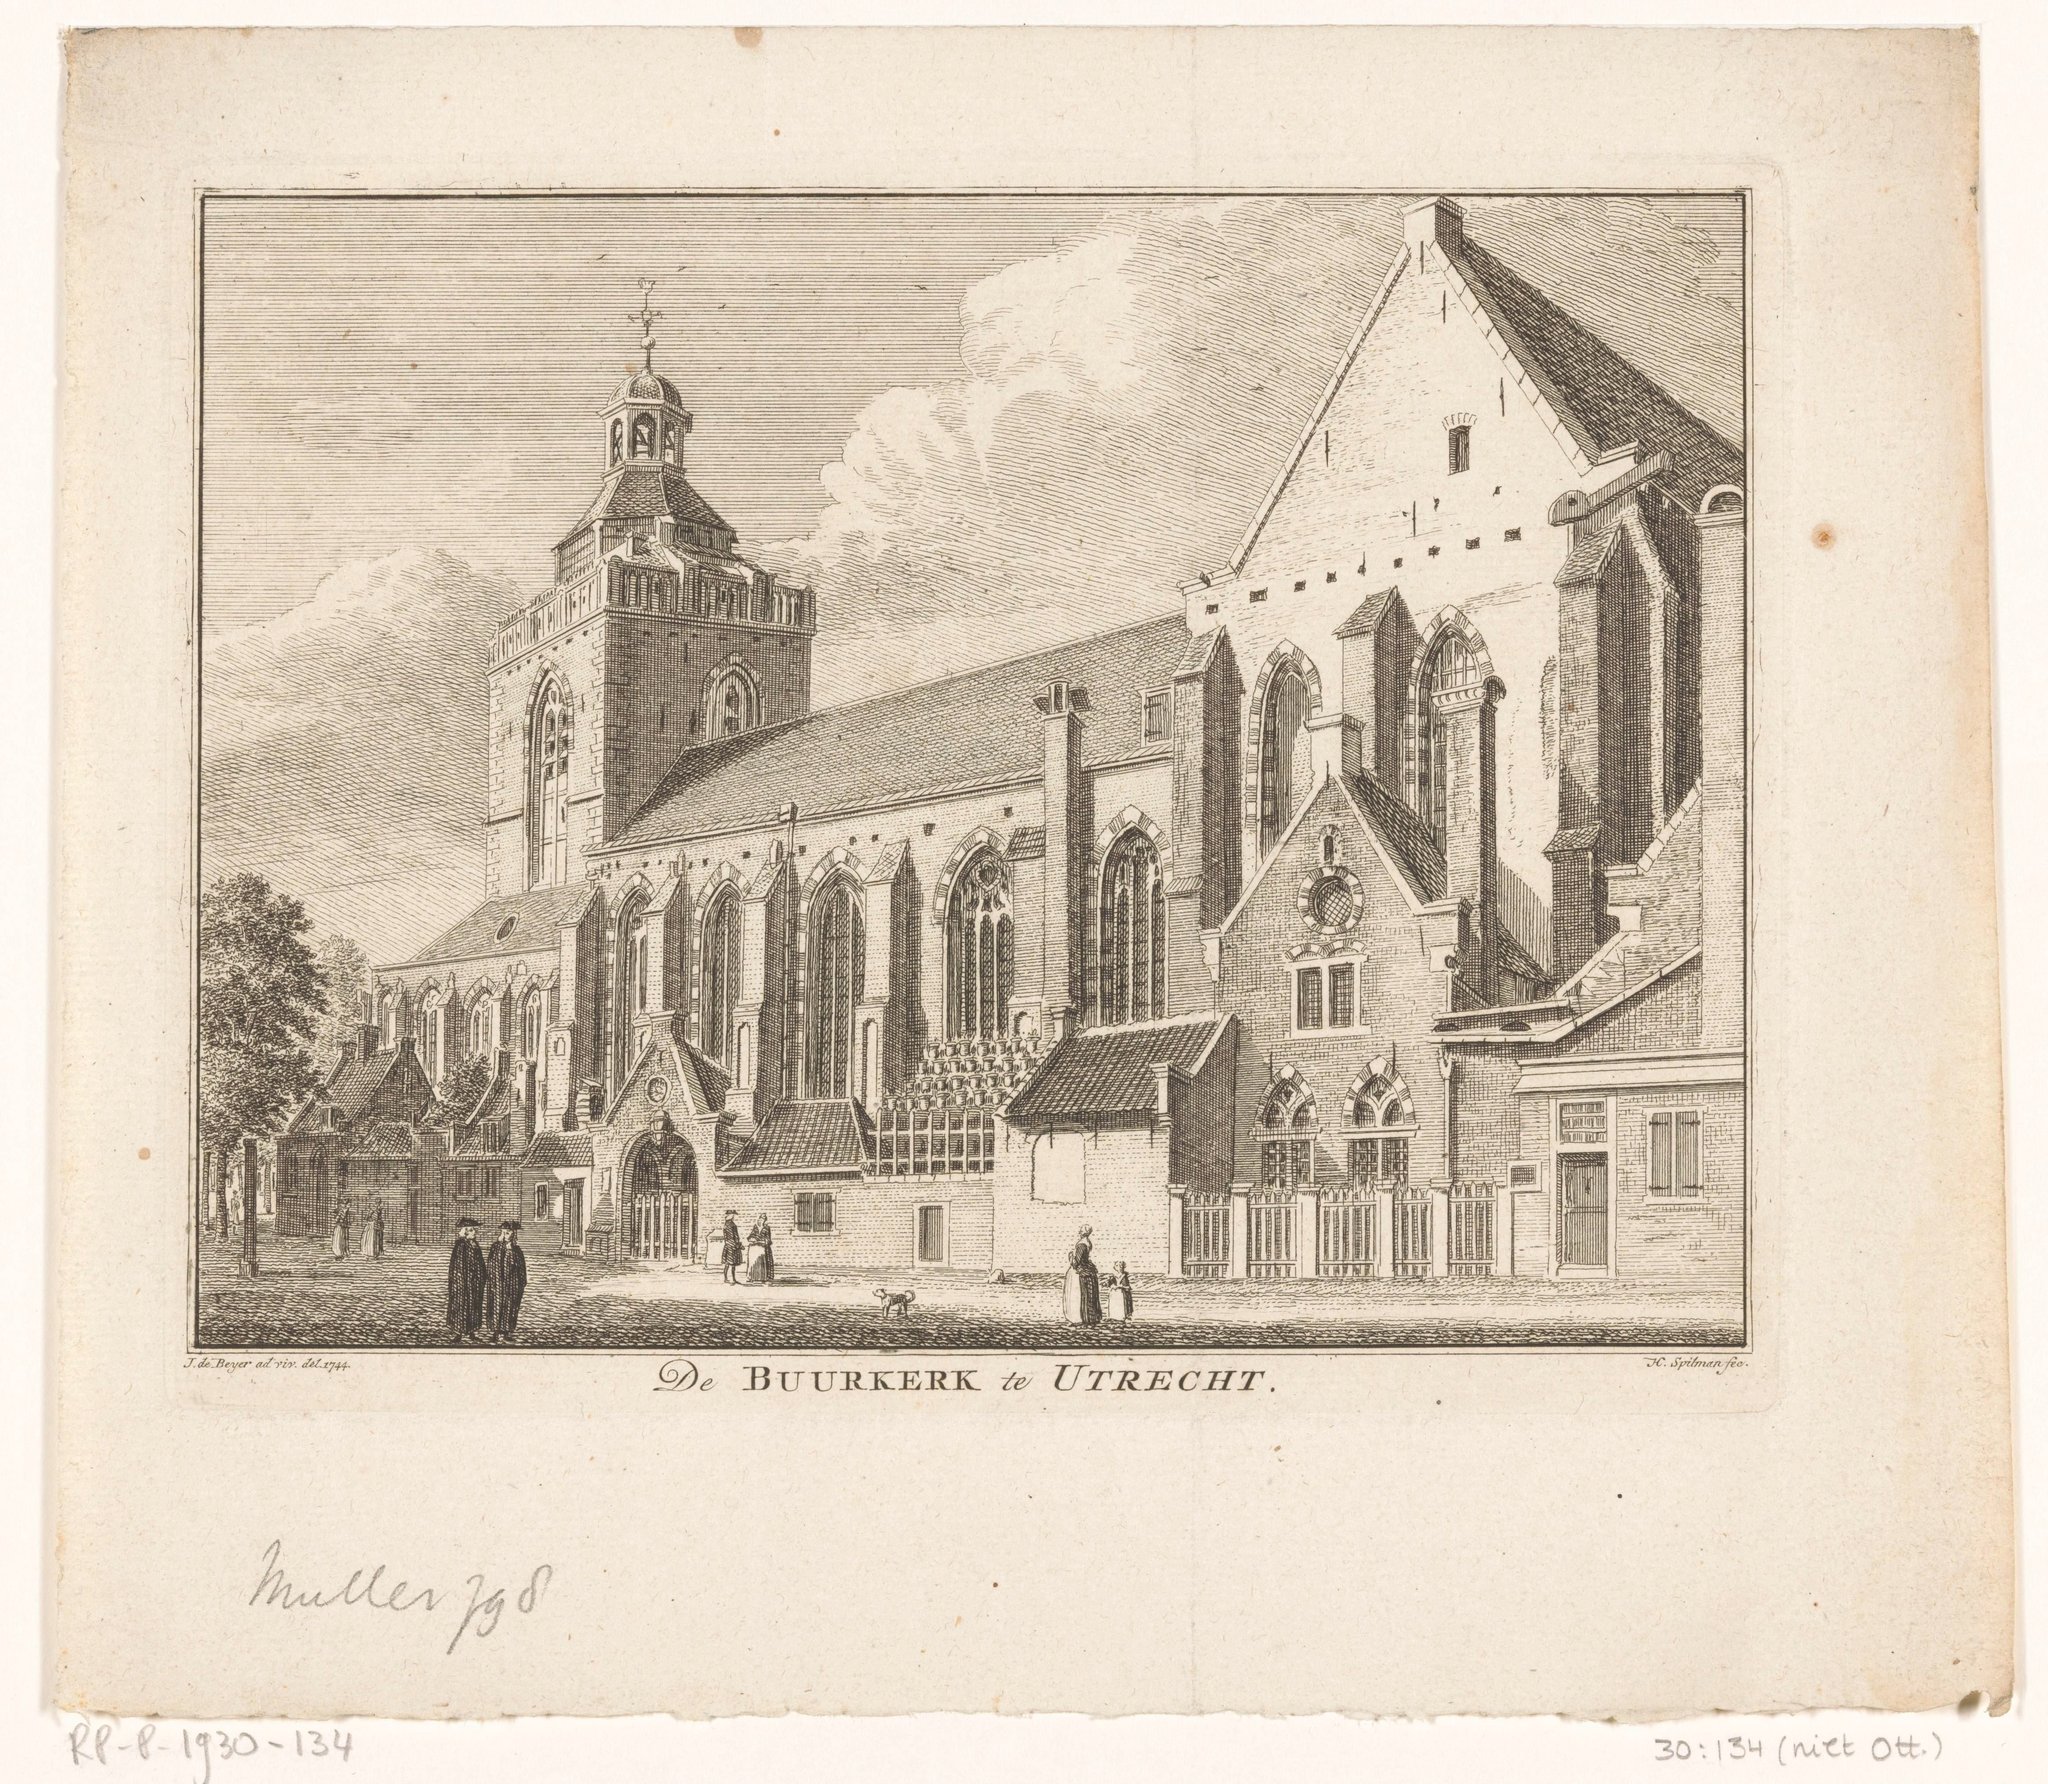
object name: print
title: Gezicht op de Buurkerk te Utrecht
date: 1744-1758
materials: paper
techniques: engraving, etching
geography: amsterdam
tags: church (exterior)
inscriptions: collector's mark: Lugt 2233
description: Prent ook gebruikt in: Tegenwoordige staat der Vereenigde Nederlanden, elfde deel, behelzende eene beschryving van de provincie van Utrecht. Met landkaarten, plans der steden en printverbeeldingen versierd / Hedendaagsche historie, of tegenwoordige staat van alle volkeren; XXI. deel (…). Amsterdam: Isaak Tirion, 1758, tussen p. 374 en p. 375.